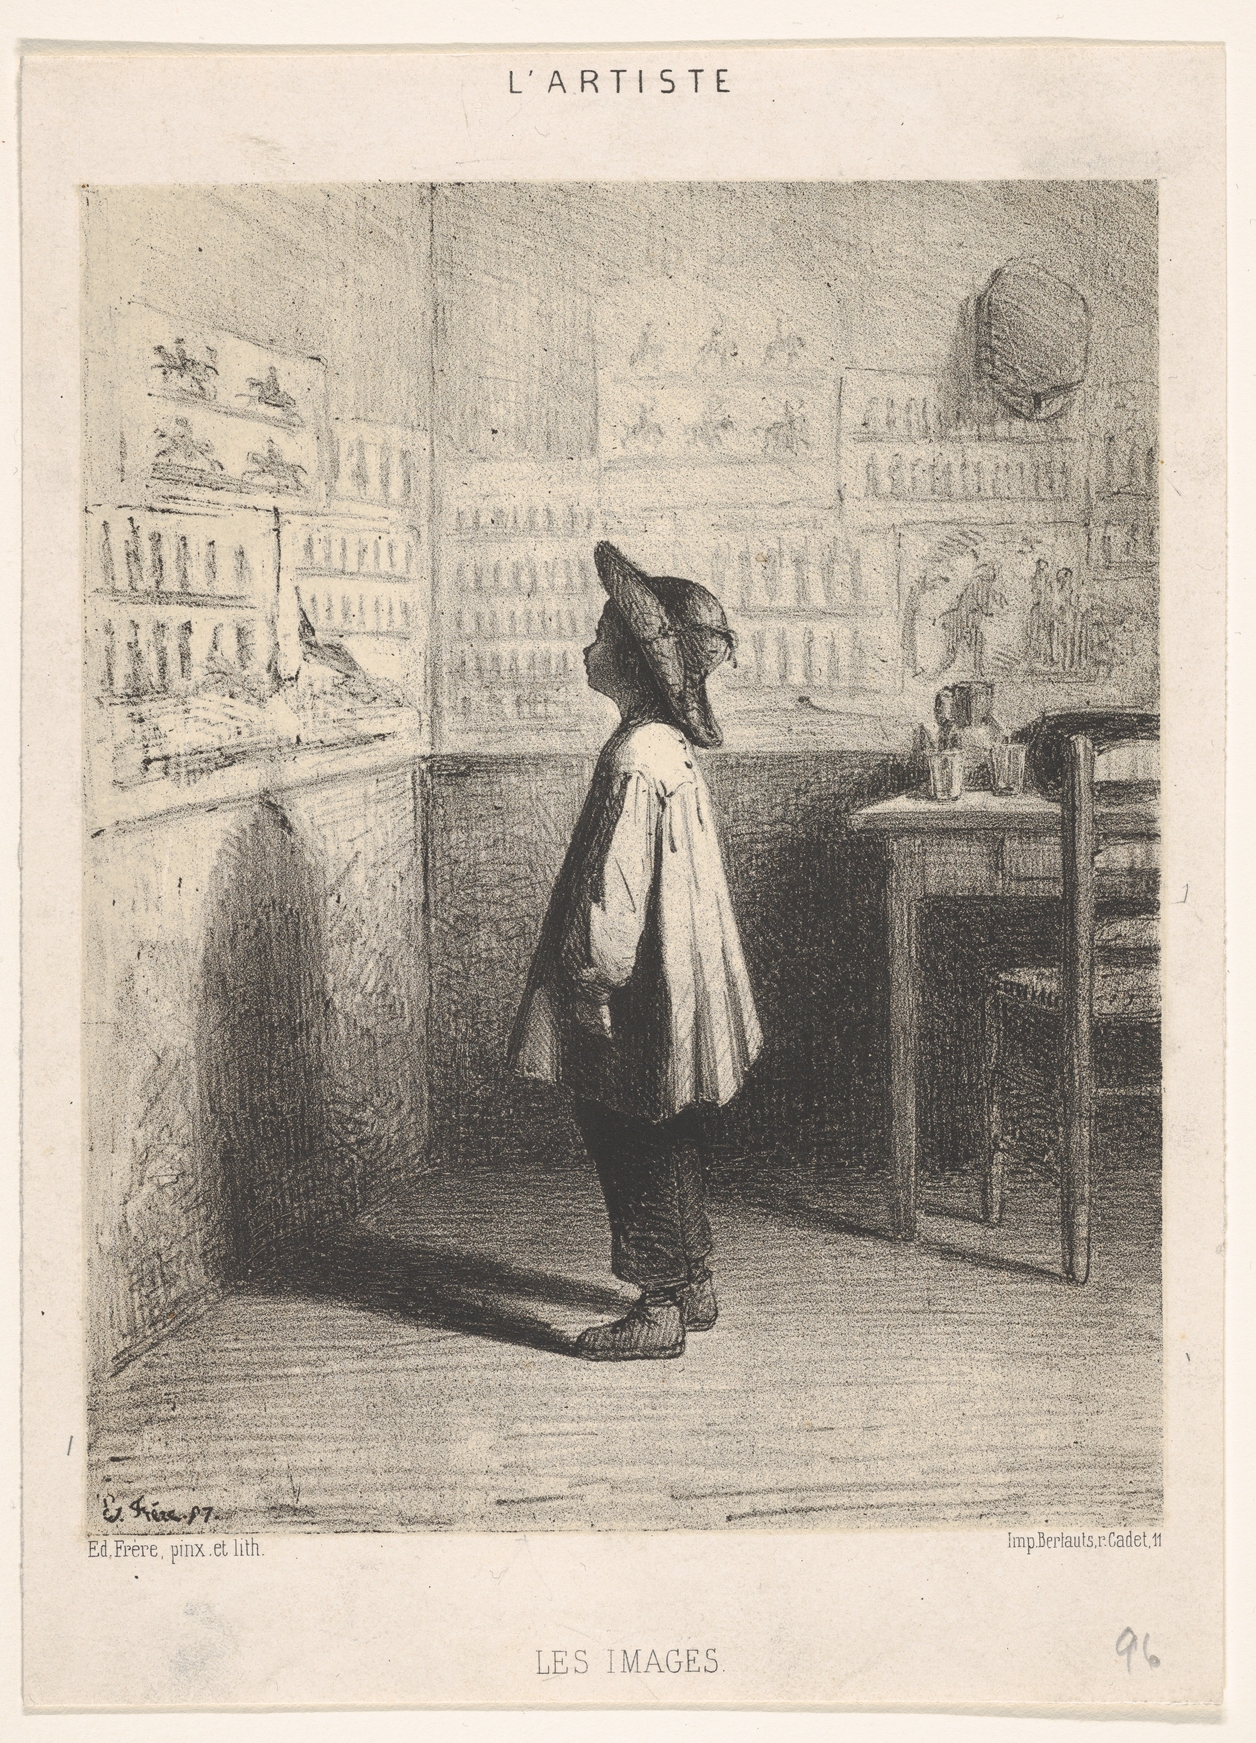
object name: print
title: Images, from "L'Artiste"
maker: pierre-edouard frère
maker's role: artist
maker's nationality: french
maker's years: 1819-1886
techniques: lithograph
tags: girls